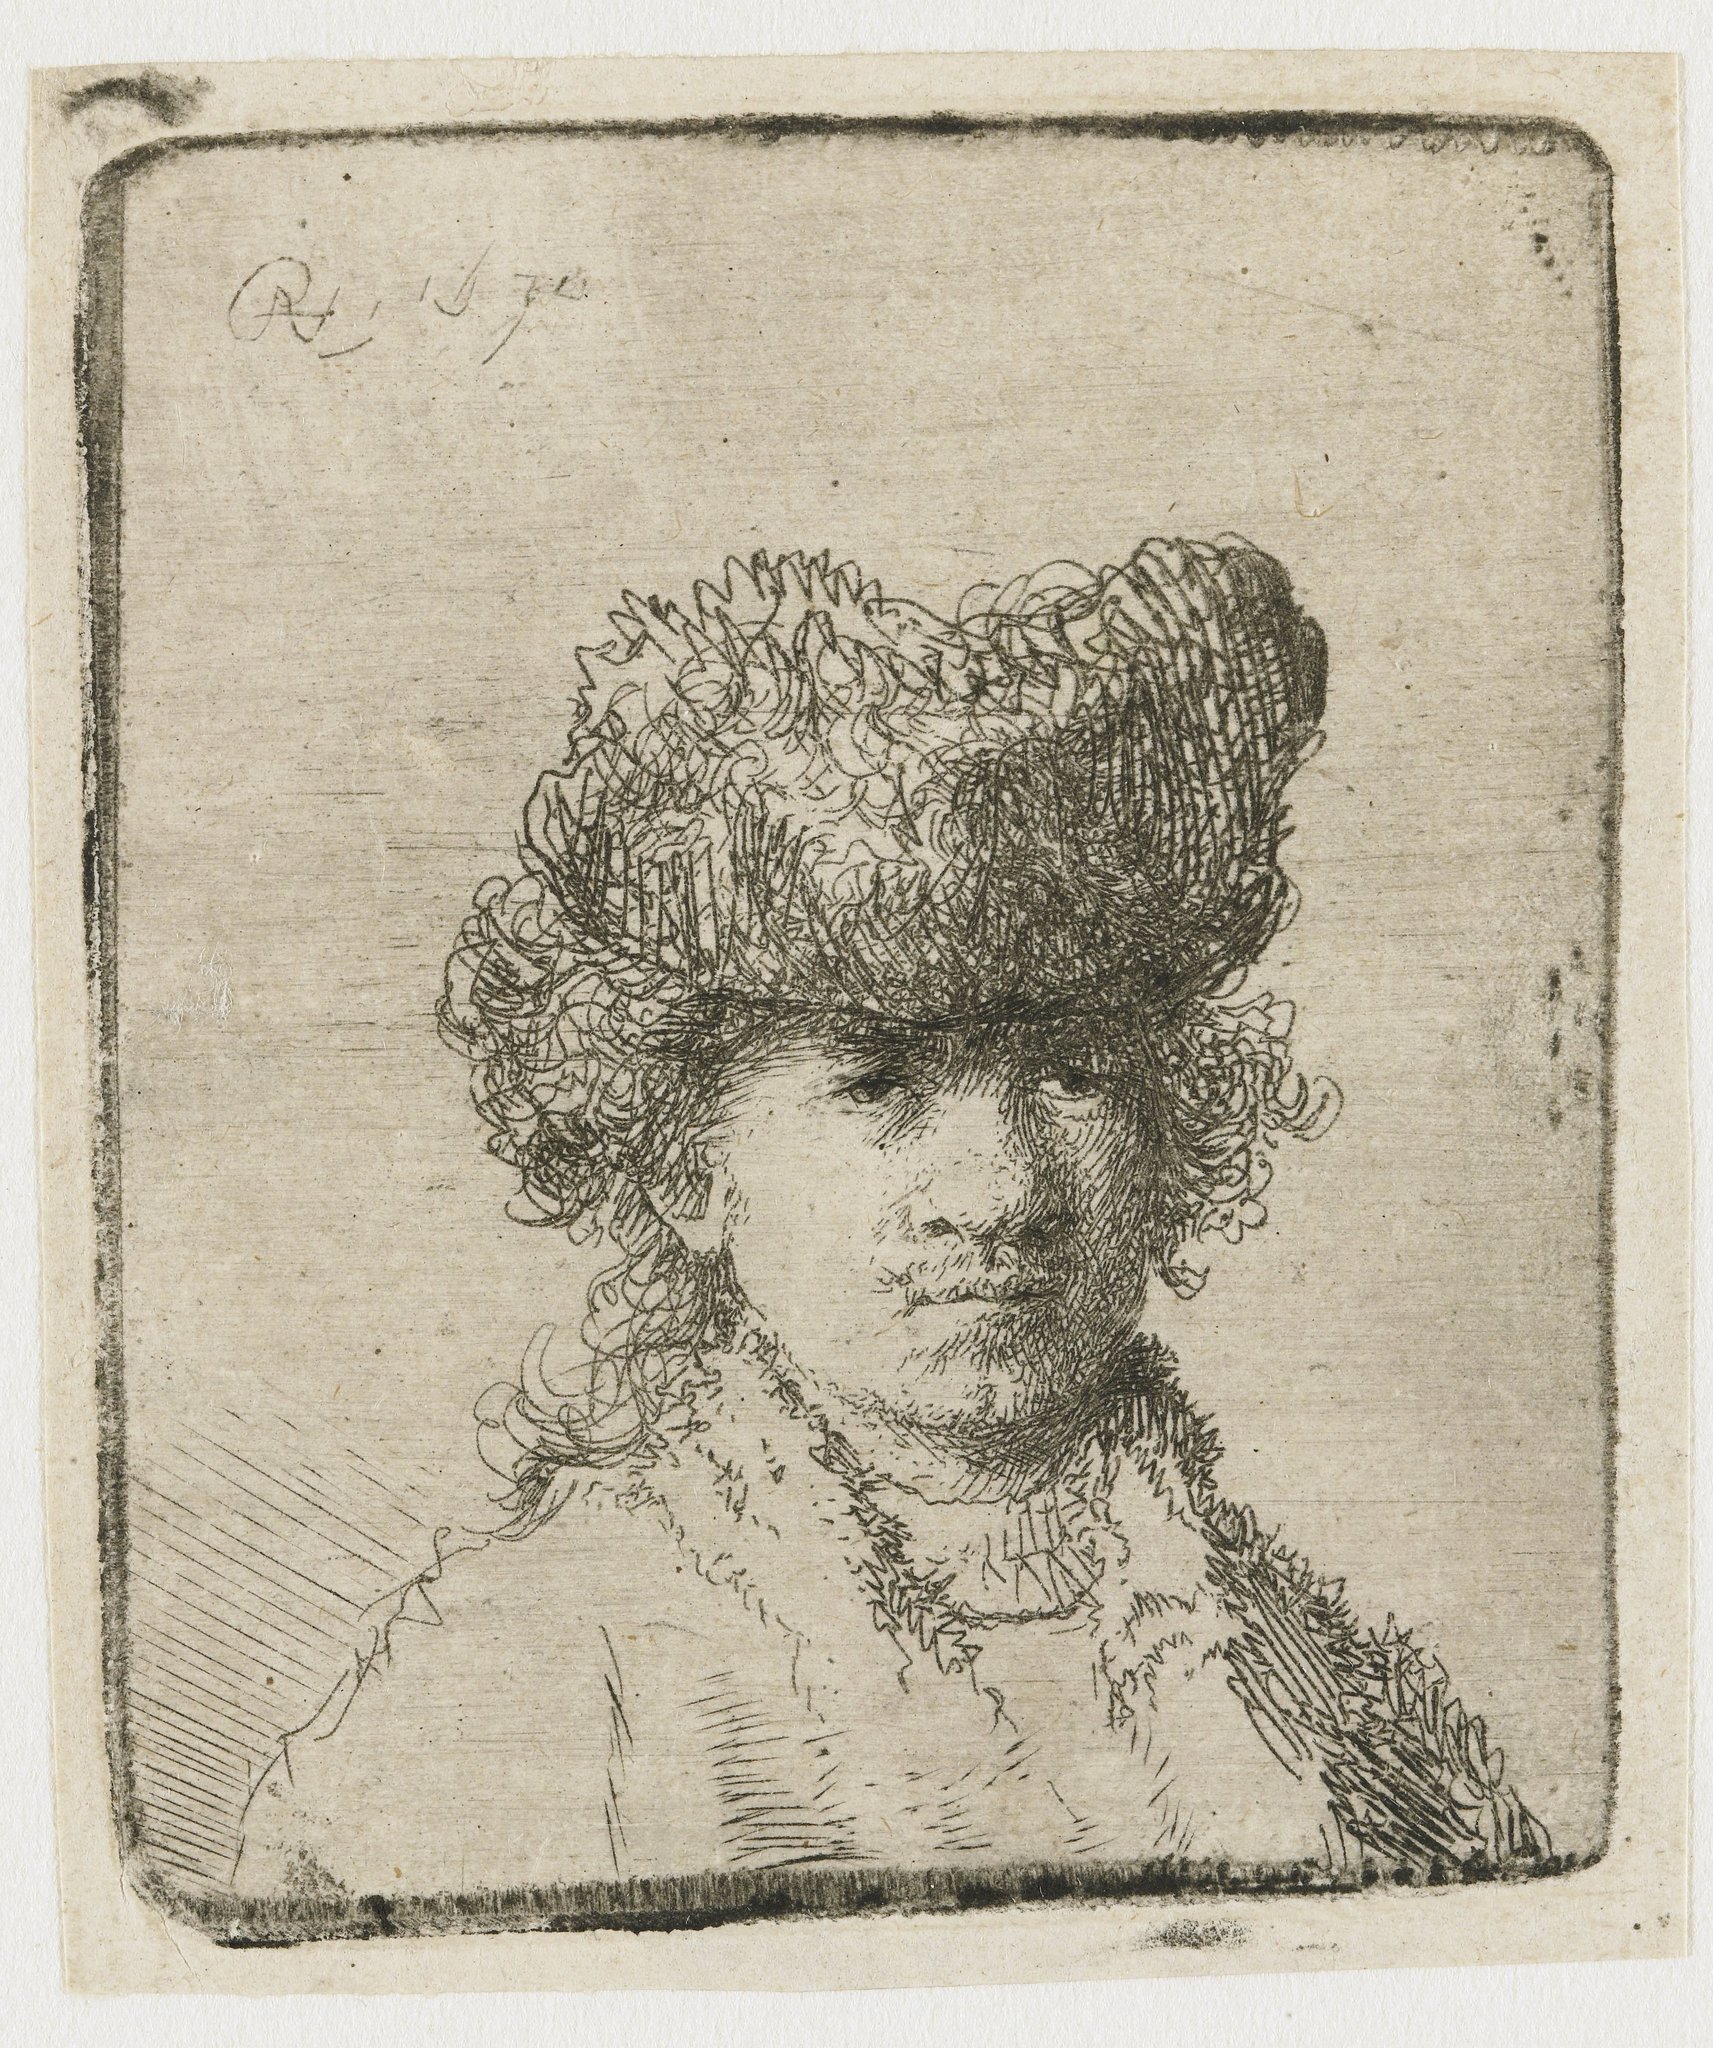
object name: print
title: Self-portrait in a fur cap: bust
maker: rembrandt van rijn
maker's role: draughtsman, painter, print maker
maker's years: 1606-1669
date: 1630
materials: paper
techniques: etching, intaglio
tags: amsterdam, painter, draughtsman, rembrandt van rijn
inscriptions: collector's mark: Lugt 240, monogram and date: ‘RHL 1630’